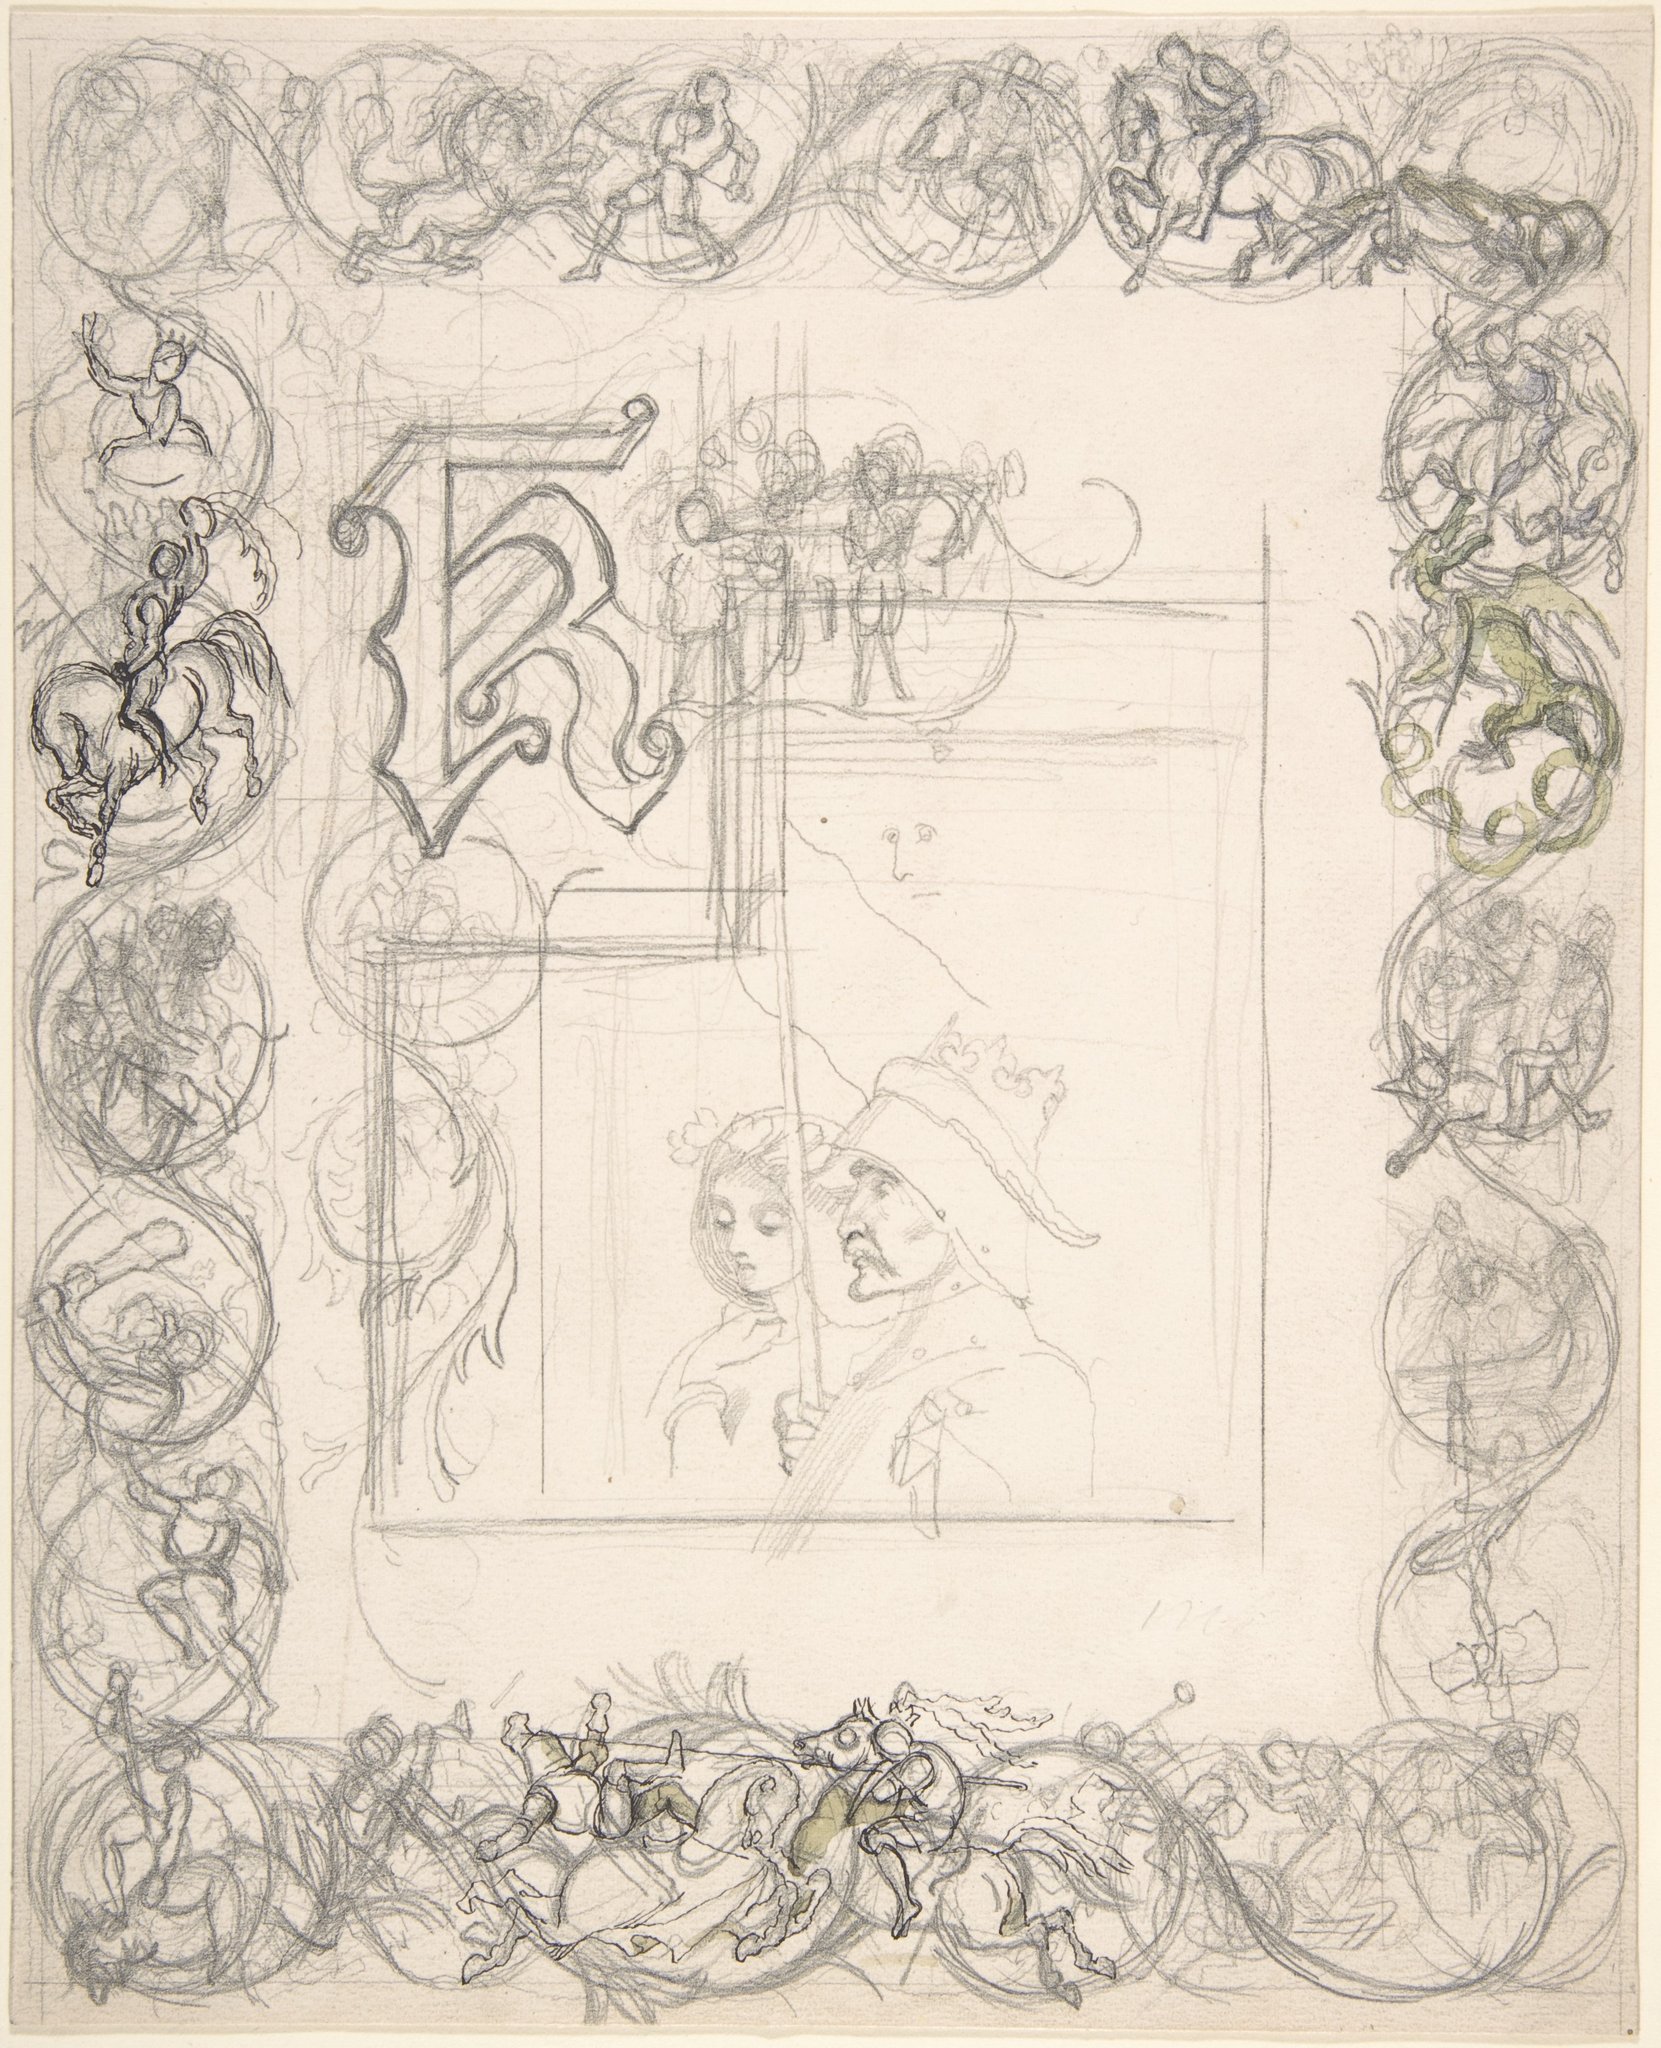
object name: drawing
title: Border design with knights, ladies and dragons (recto); Sketches for border elements (verso)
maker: richard doyle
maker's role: artist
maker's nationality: british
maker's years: 1824-1883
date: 1855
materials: graphite, ink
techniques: brush, pen, wash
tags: men,profiles,women